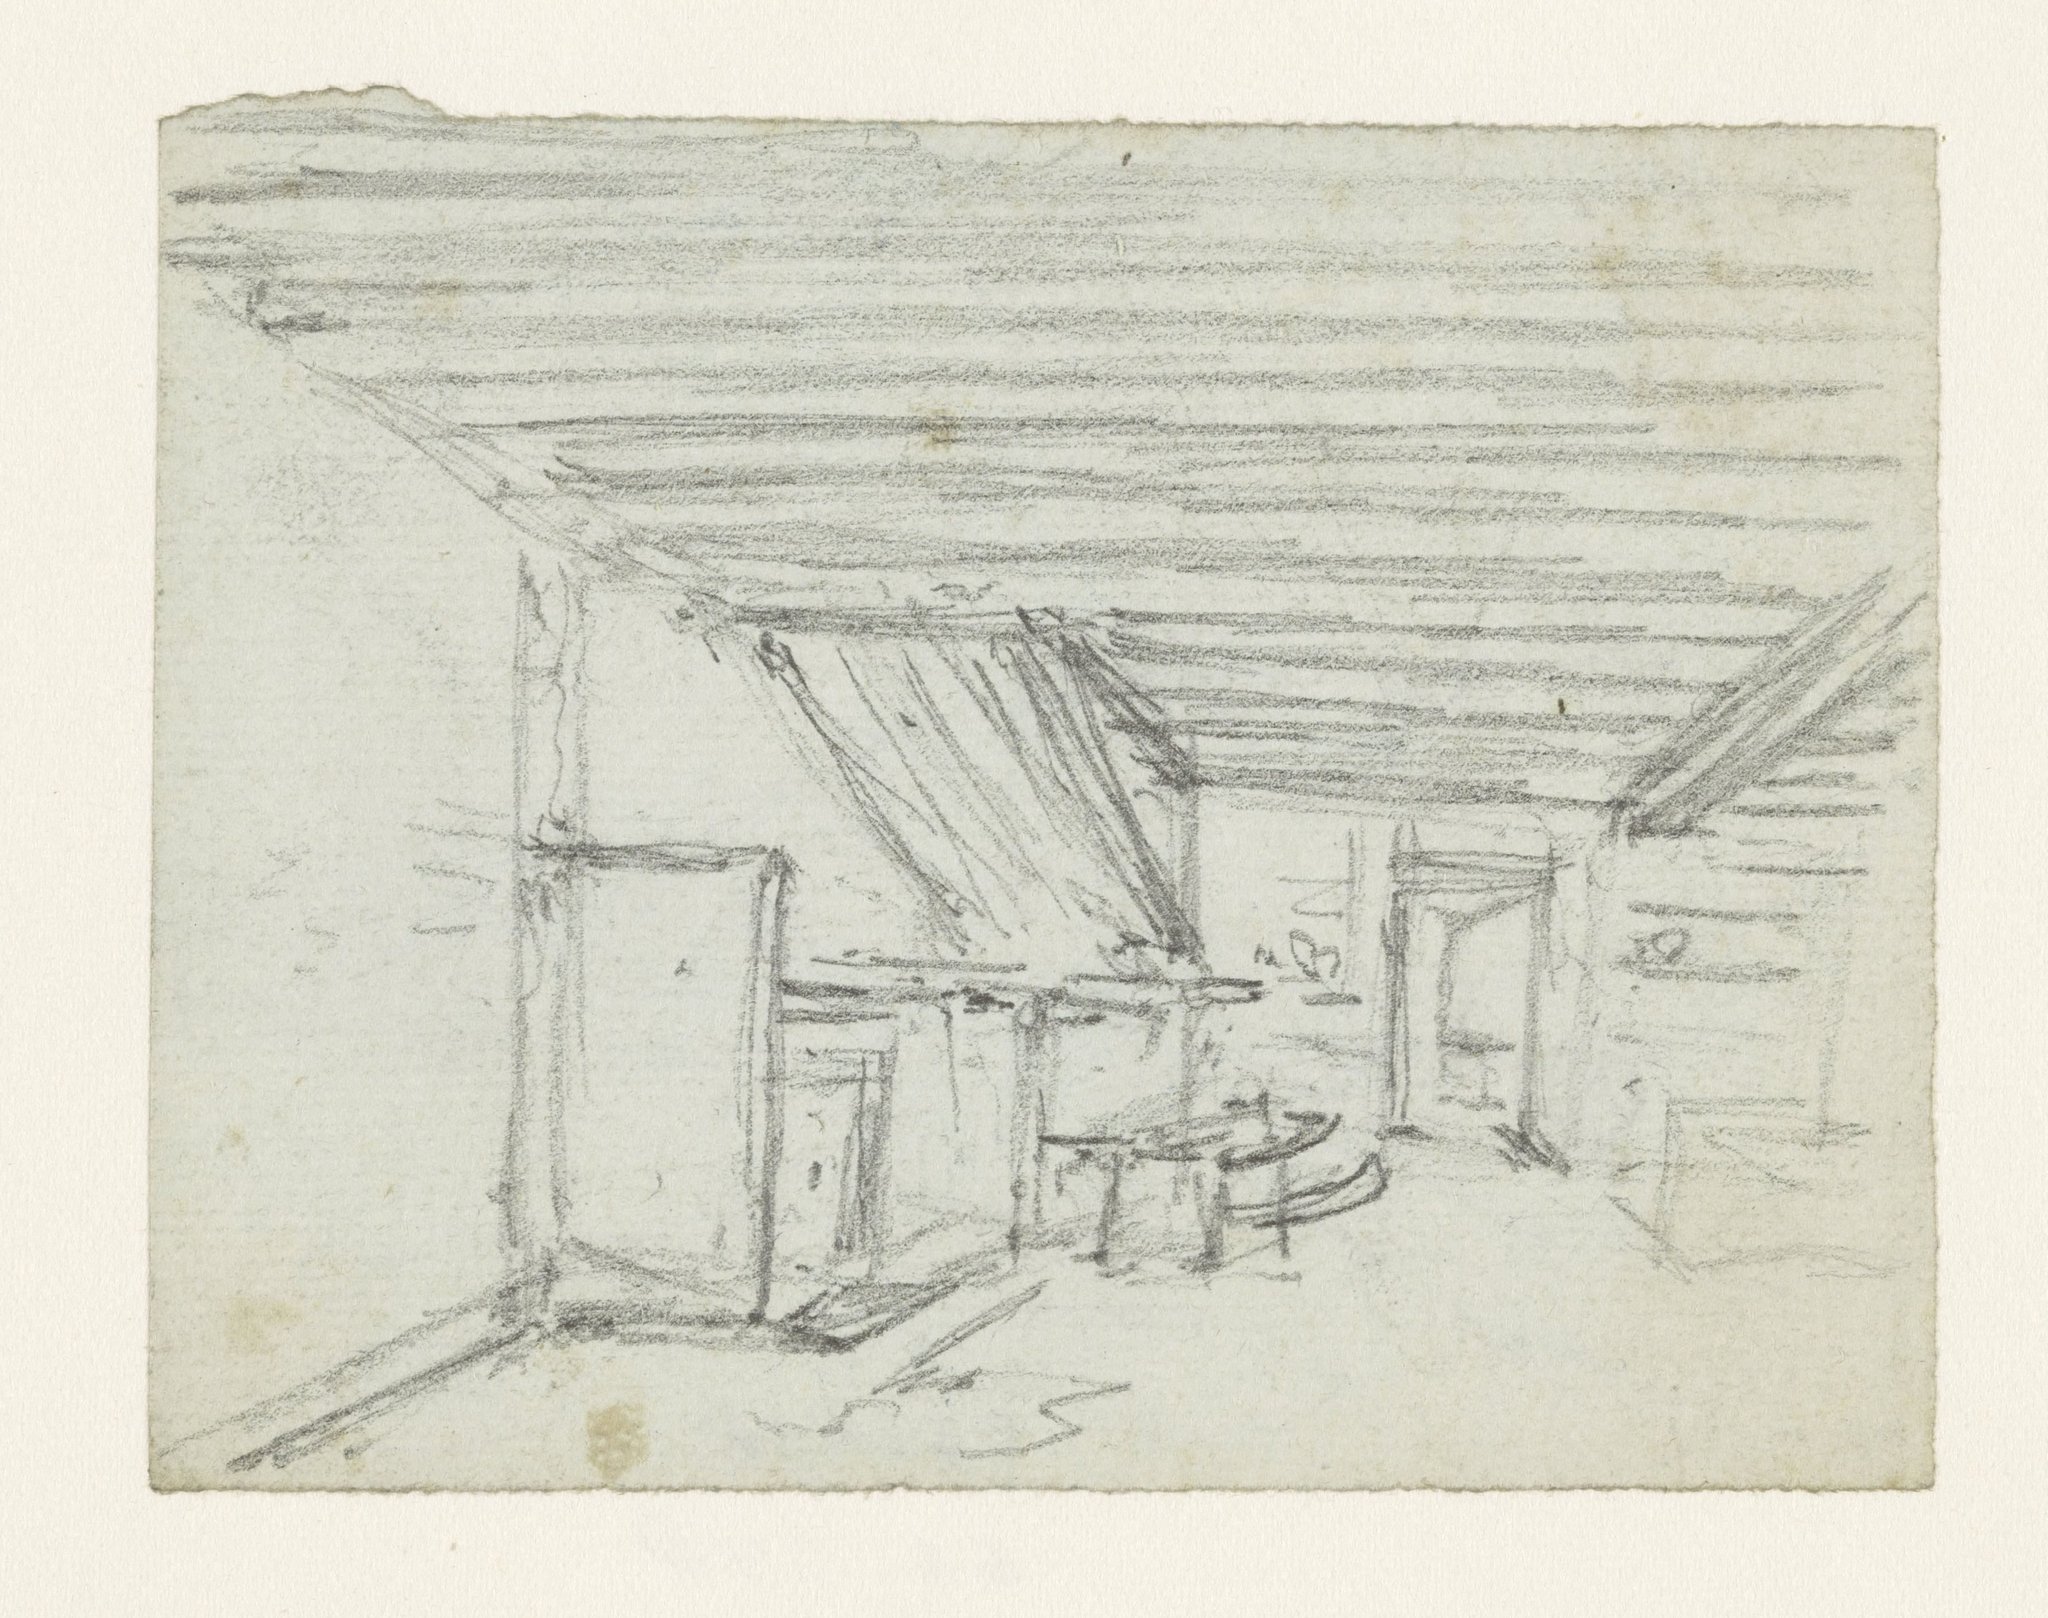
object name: drawing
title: Interieur van een boerderij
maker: georges michel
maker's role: draughtsman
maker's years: 1763-1843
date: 1773-1843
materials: paper, pencil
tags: farm or solitary house in landscape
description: Een van 120 tekeningen, afkomstig uit een 19e eeuws album met tekeningen van Georges Michel.